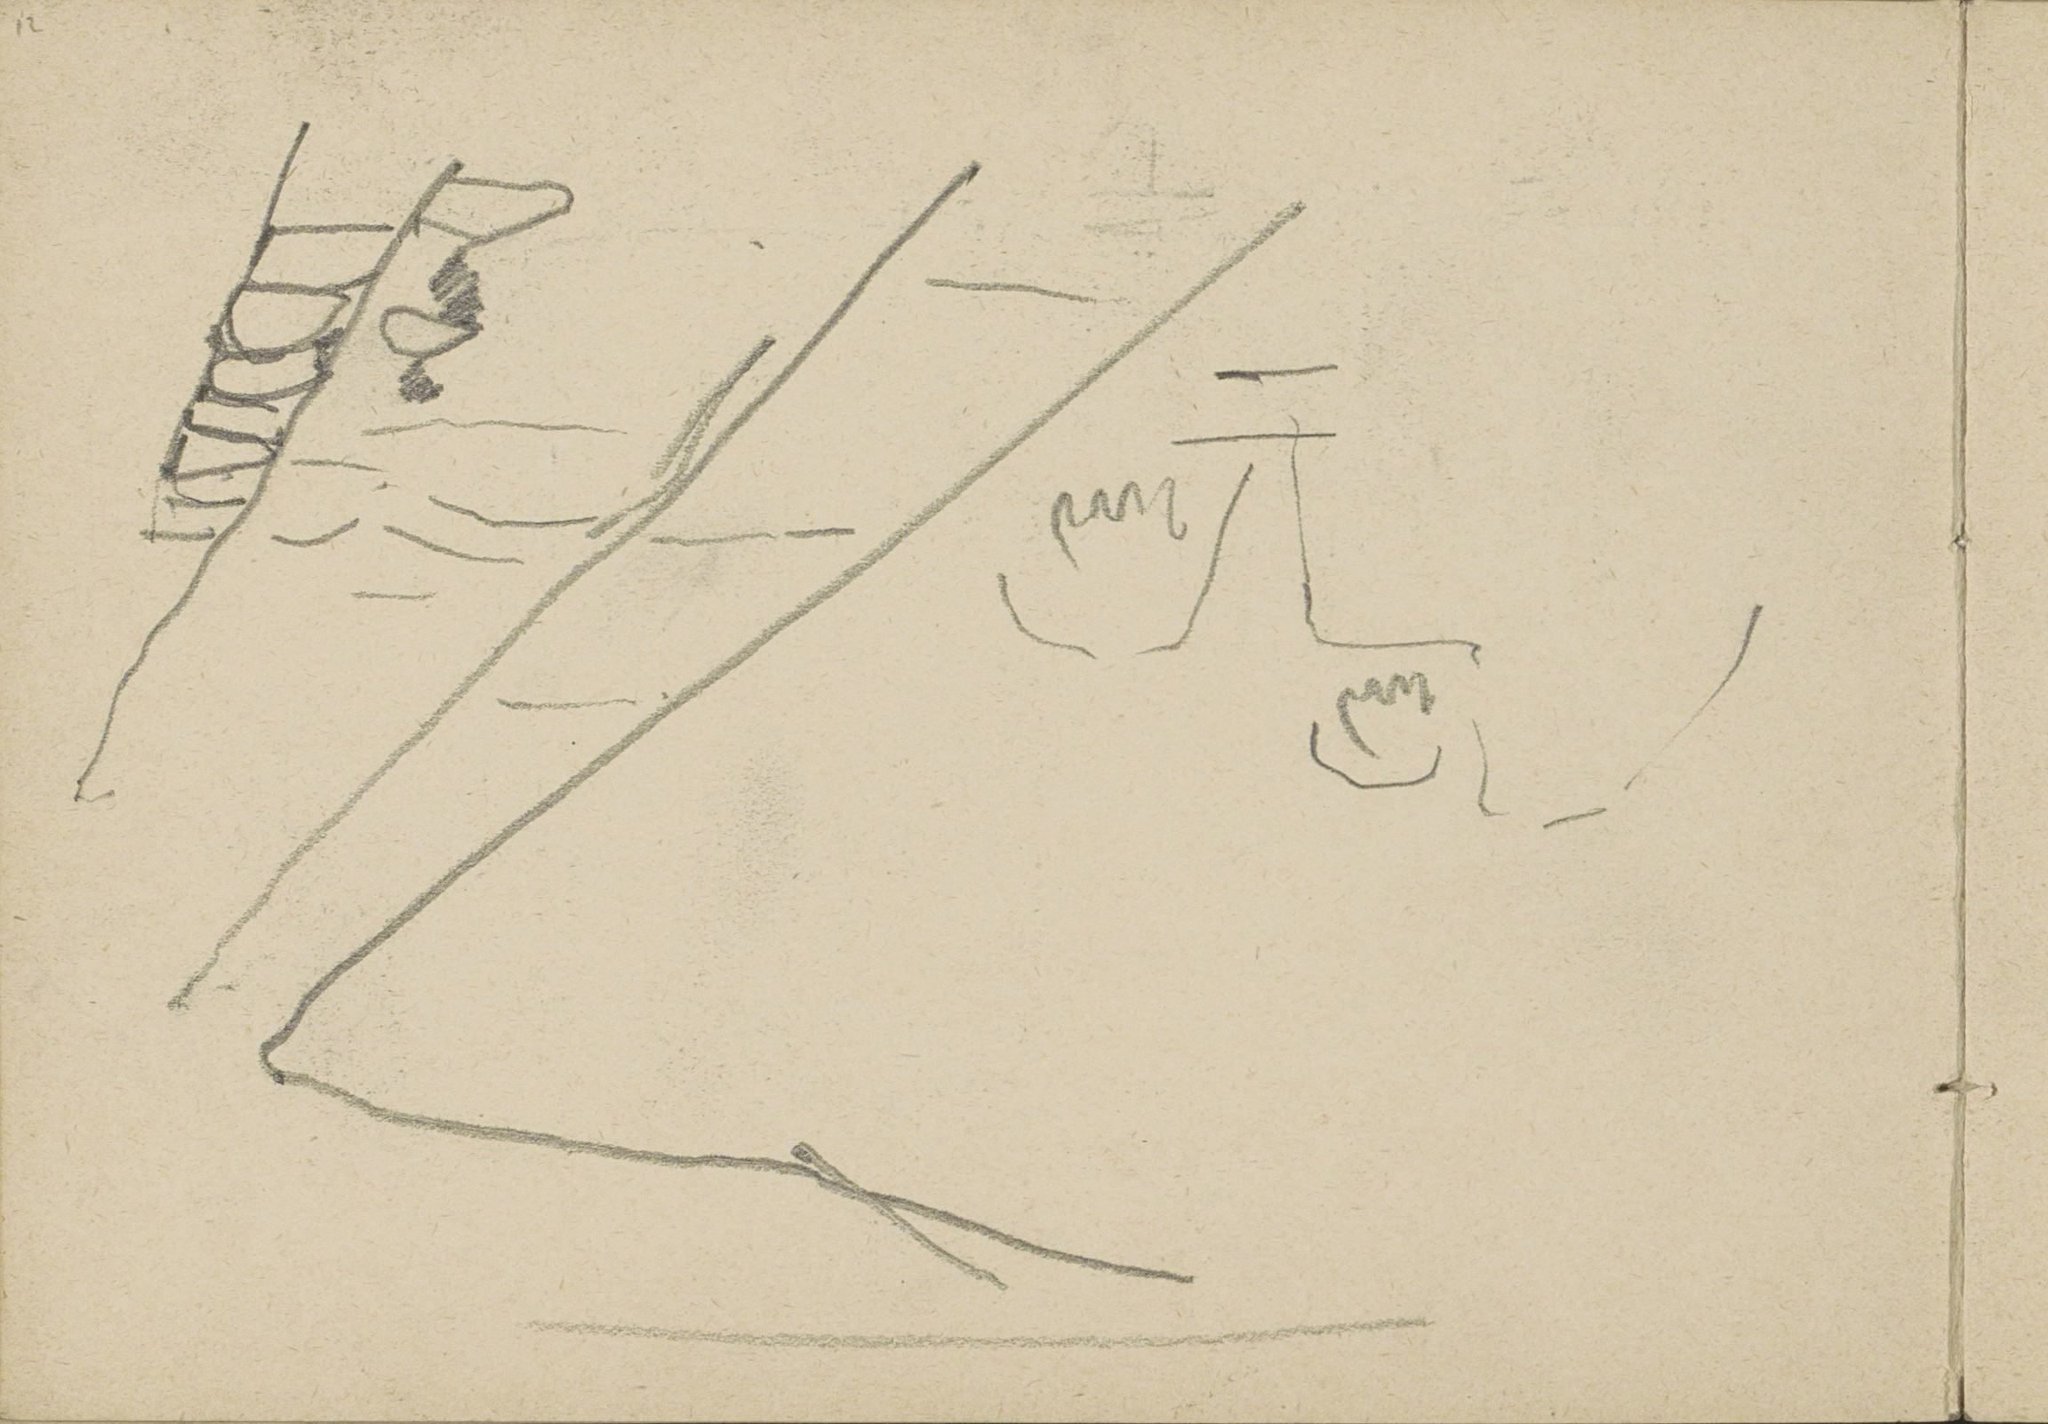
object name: sketchbook leaf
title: Studie, mogelijk van een straat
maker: willem witsen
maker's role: draughtsman, painter, print maker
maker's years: 1860-1923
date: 1870-1923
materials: paper, pencil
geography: amsterdam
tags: street, amsterdam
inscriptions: : ‘[...]’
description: Pagina 12 uit een schetsboek met 16 bladen.